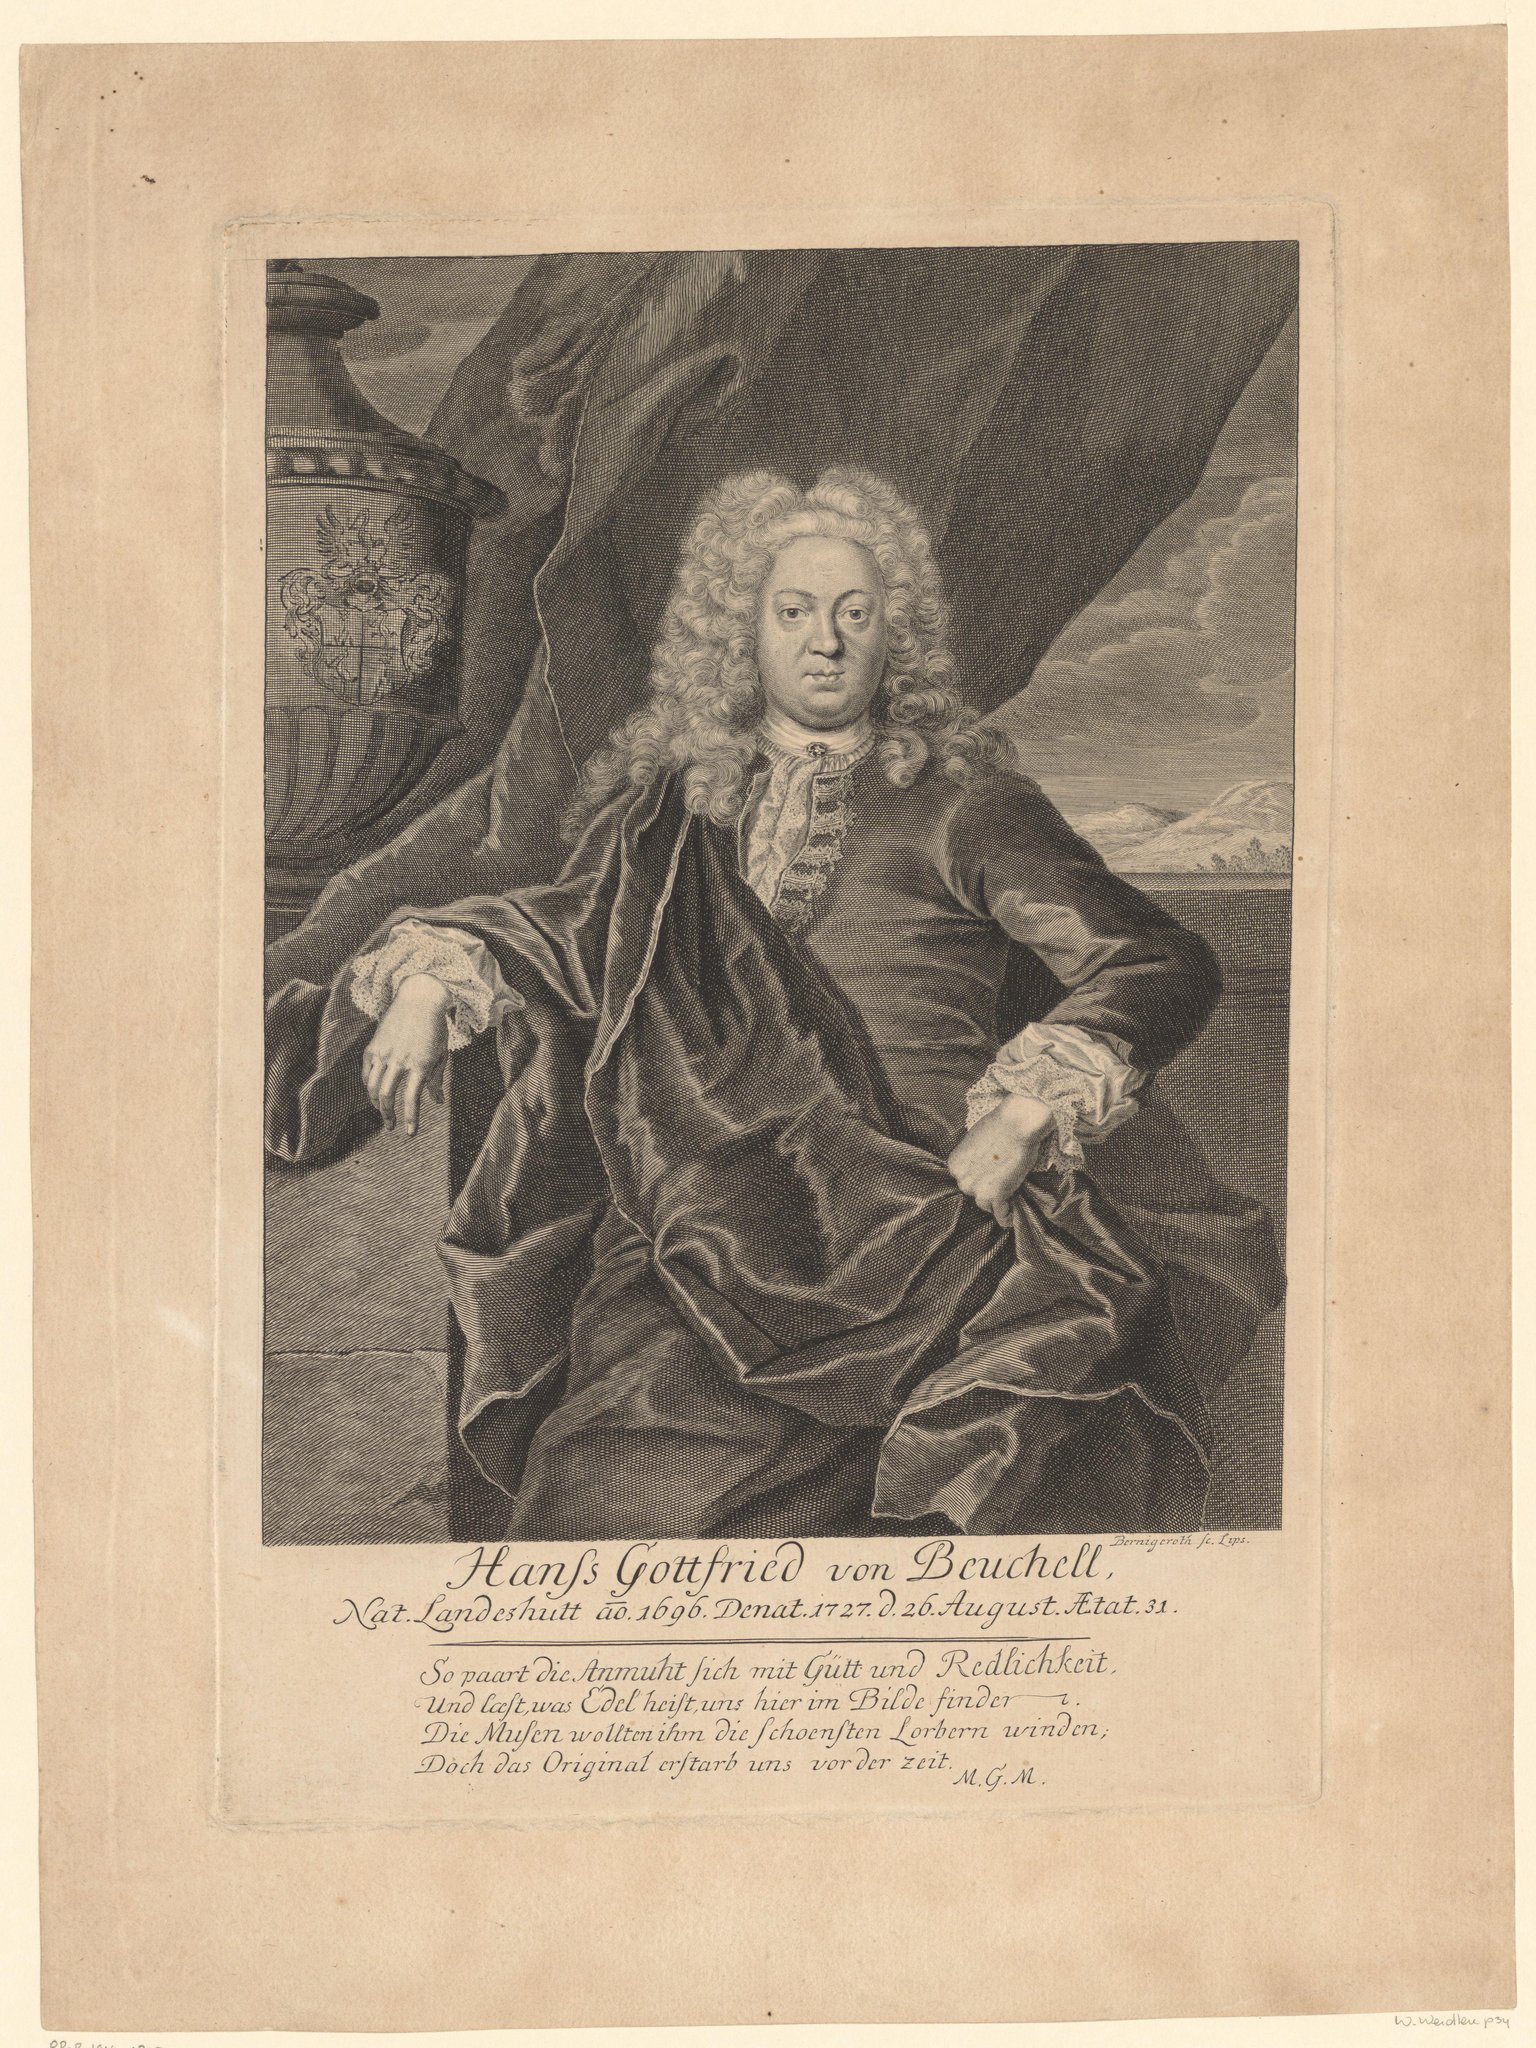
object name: print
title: Portret van Hans Gottfried von Beuchell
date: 1727-1733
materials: paper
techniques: engraving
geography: kamienna góra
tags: historical persons, armorial bearing, heraldry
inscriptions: collector's mark: Lugt 2228